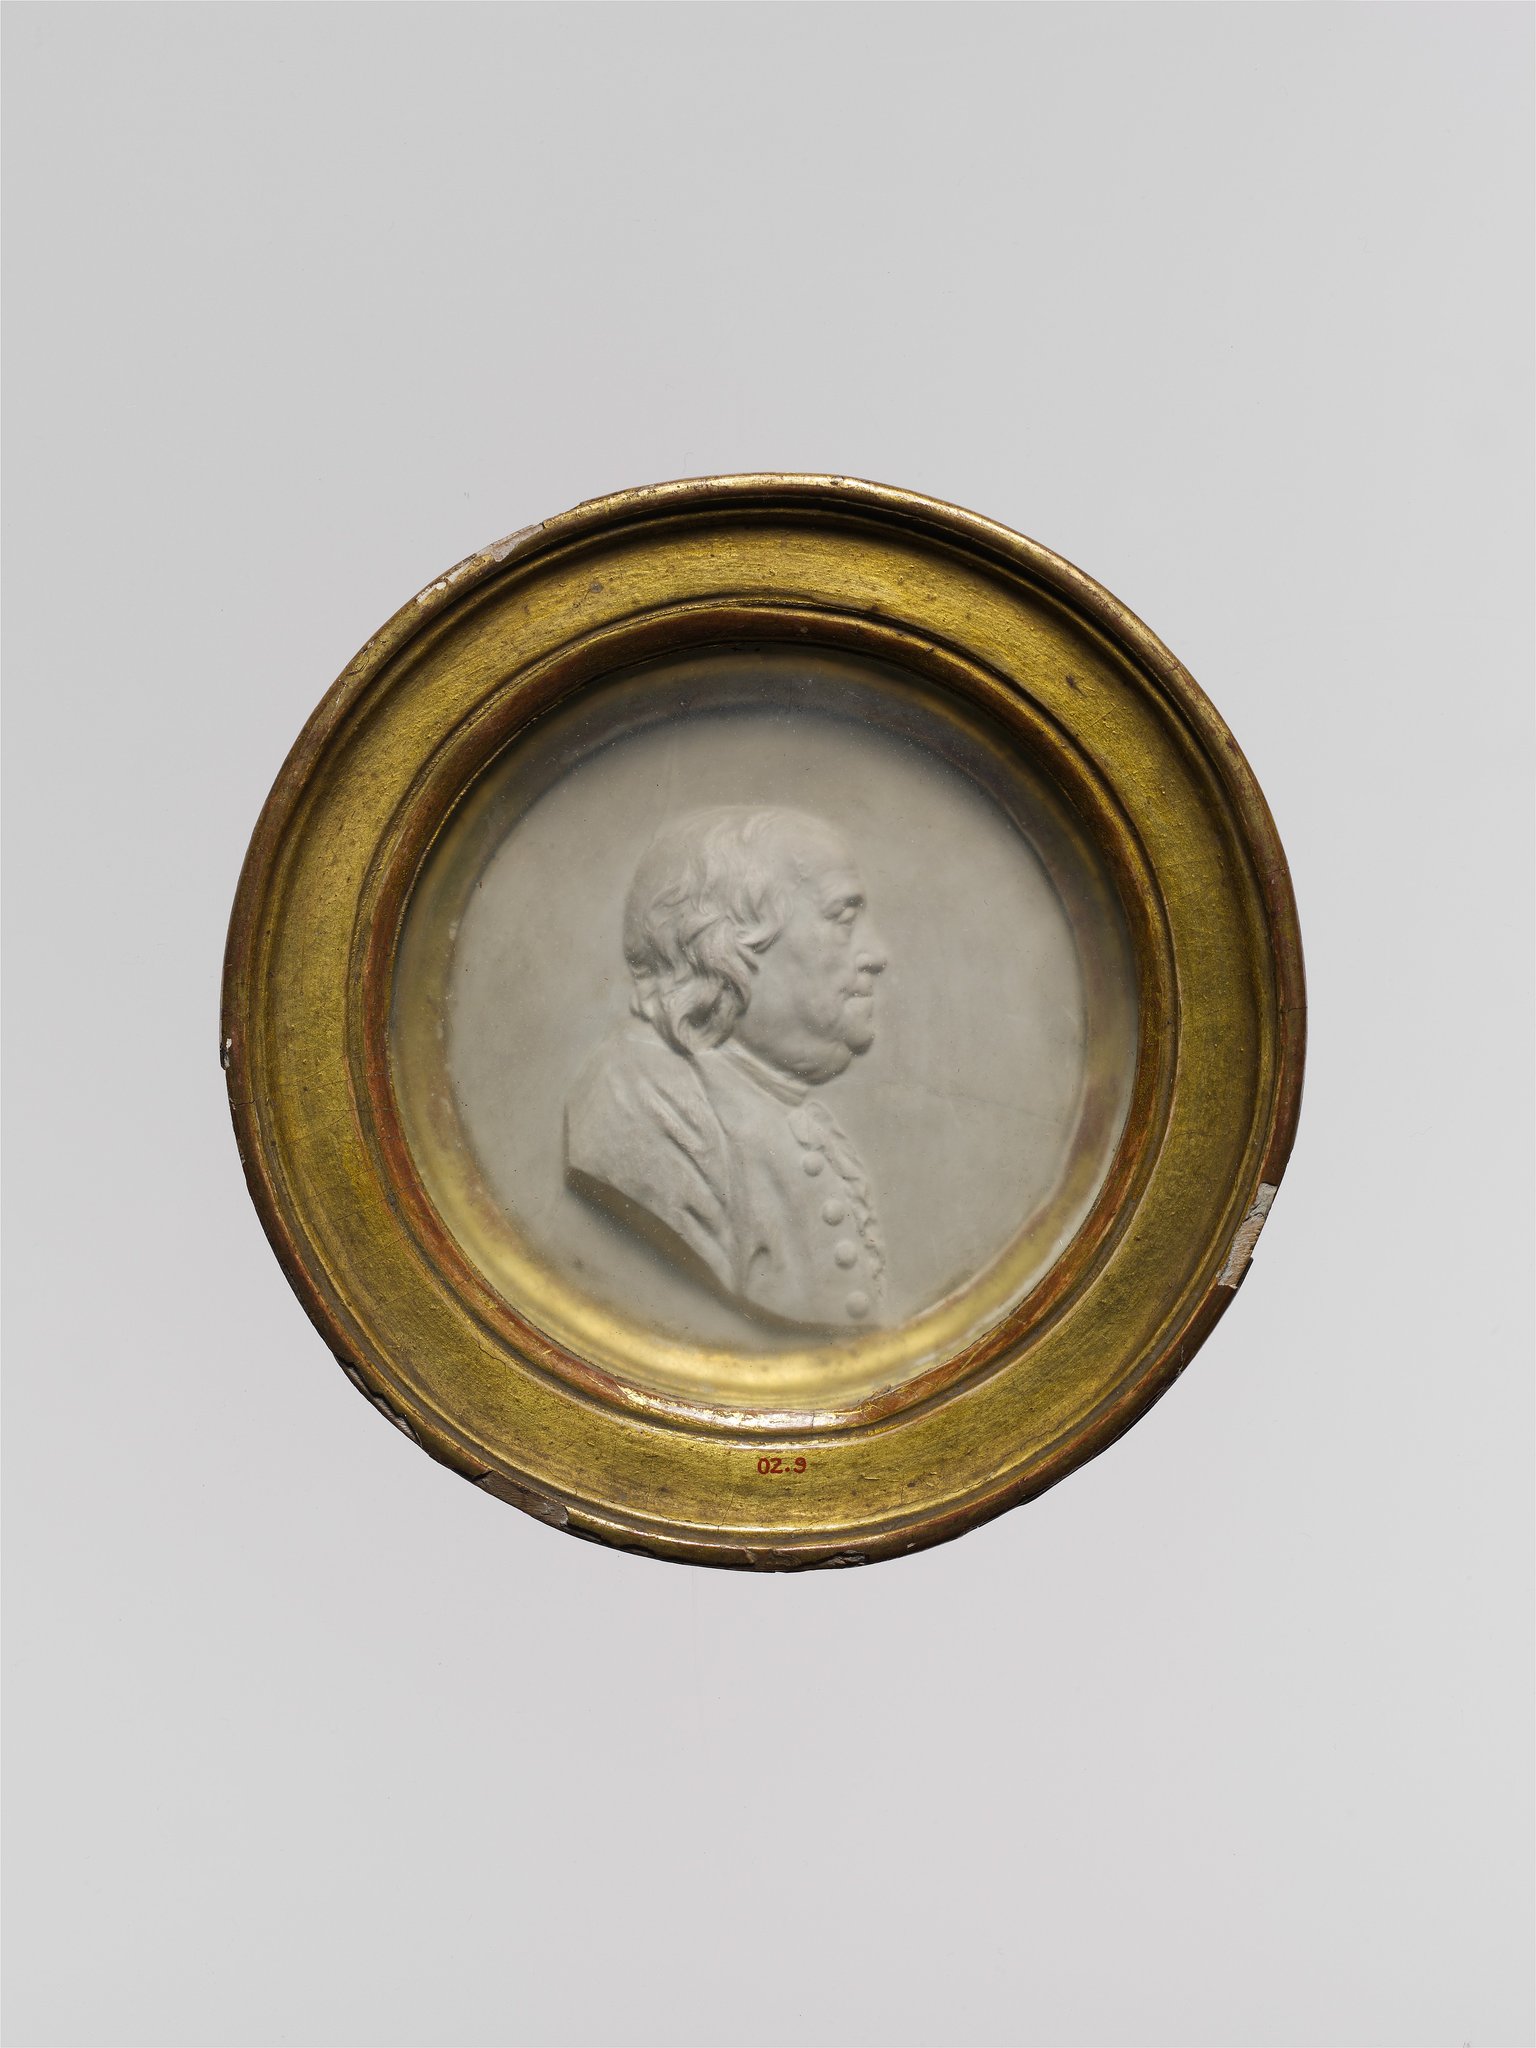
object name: medallion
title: Medallion of Benjamin Franklin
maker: jean martin renaud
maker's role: maker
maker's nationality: french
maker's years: 1746-1821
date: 1797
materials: plaster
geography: france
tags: benjamin franklin,men,profiles